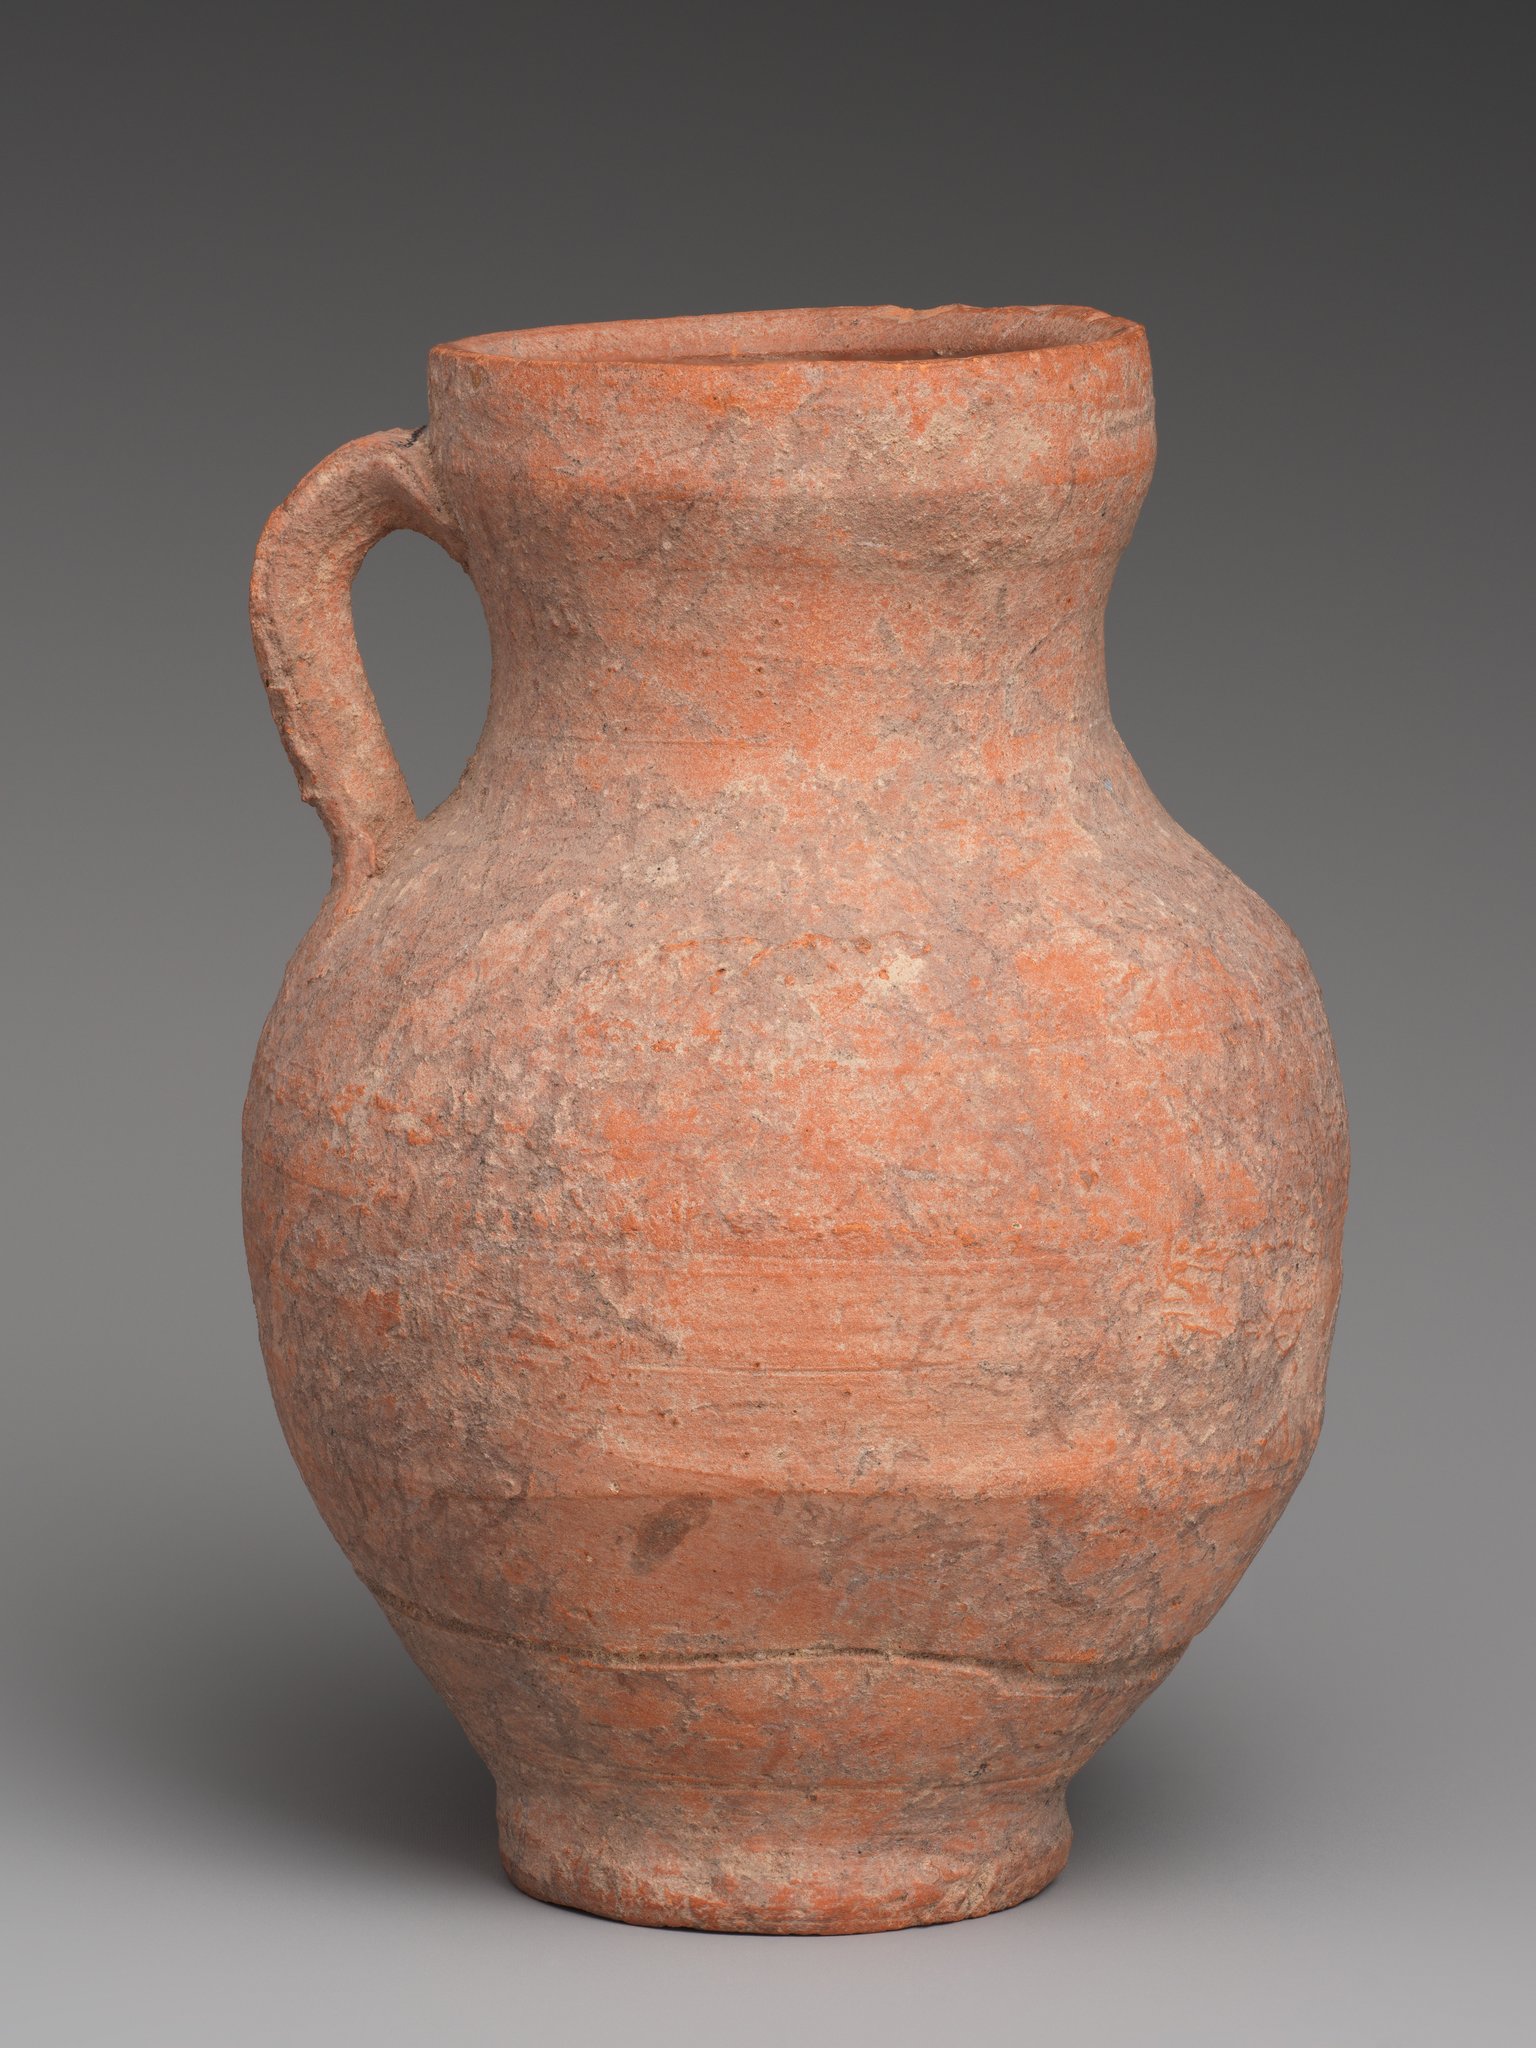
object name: vessel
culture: nabataean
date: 1-100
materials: ceramic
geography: levant